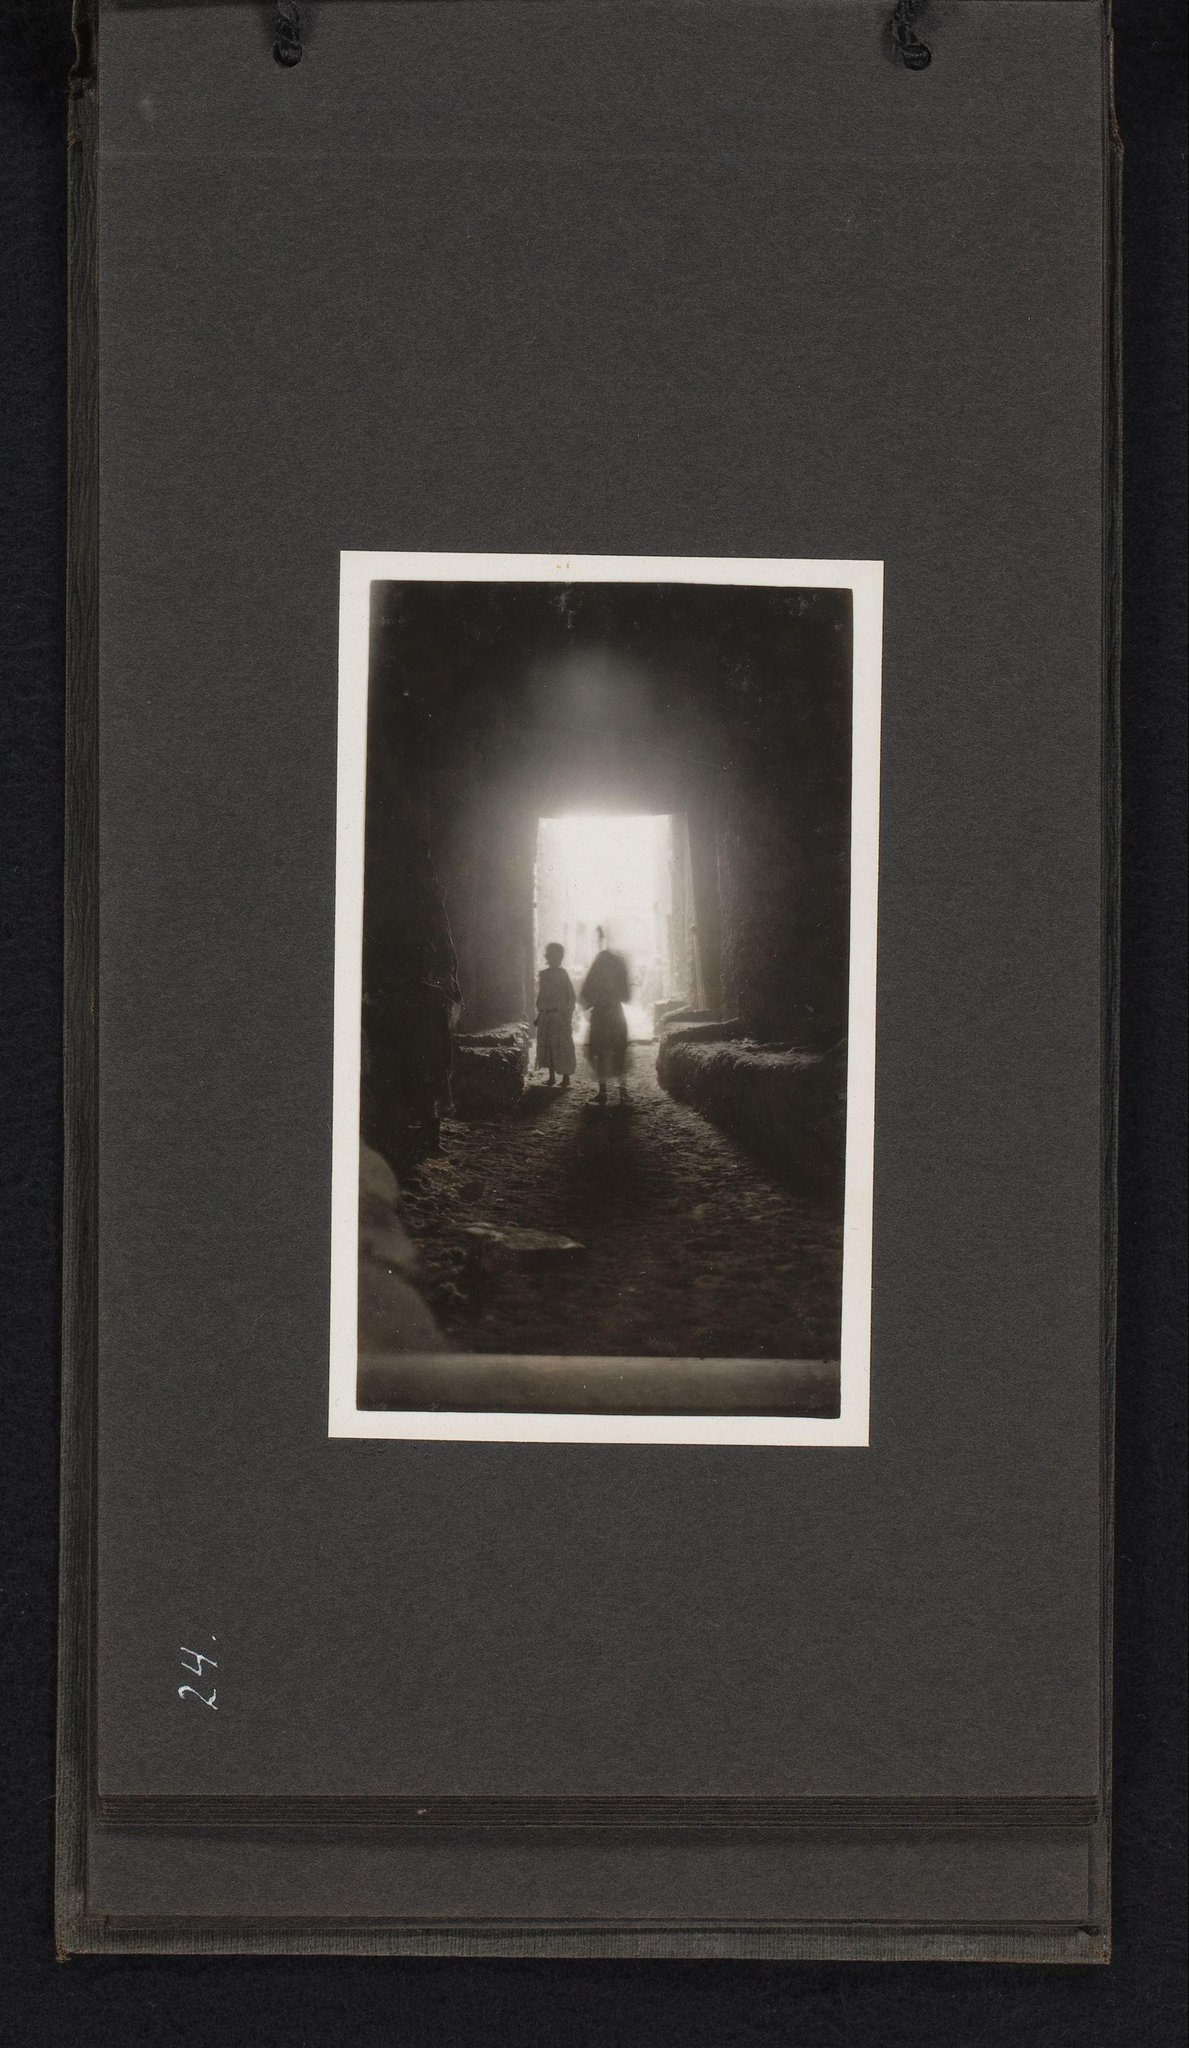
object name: album leaf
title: do. do.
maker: a.g.a. van eelde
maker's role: engineer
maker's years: 1862-1950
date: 1927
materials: paper, photographic support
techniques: gelatin silver print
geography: morocco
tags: historical persons, lane, alley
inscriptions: number: ‘24.’